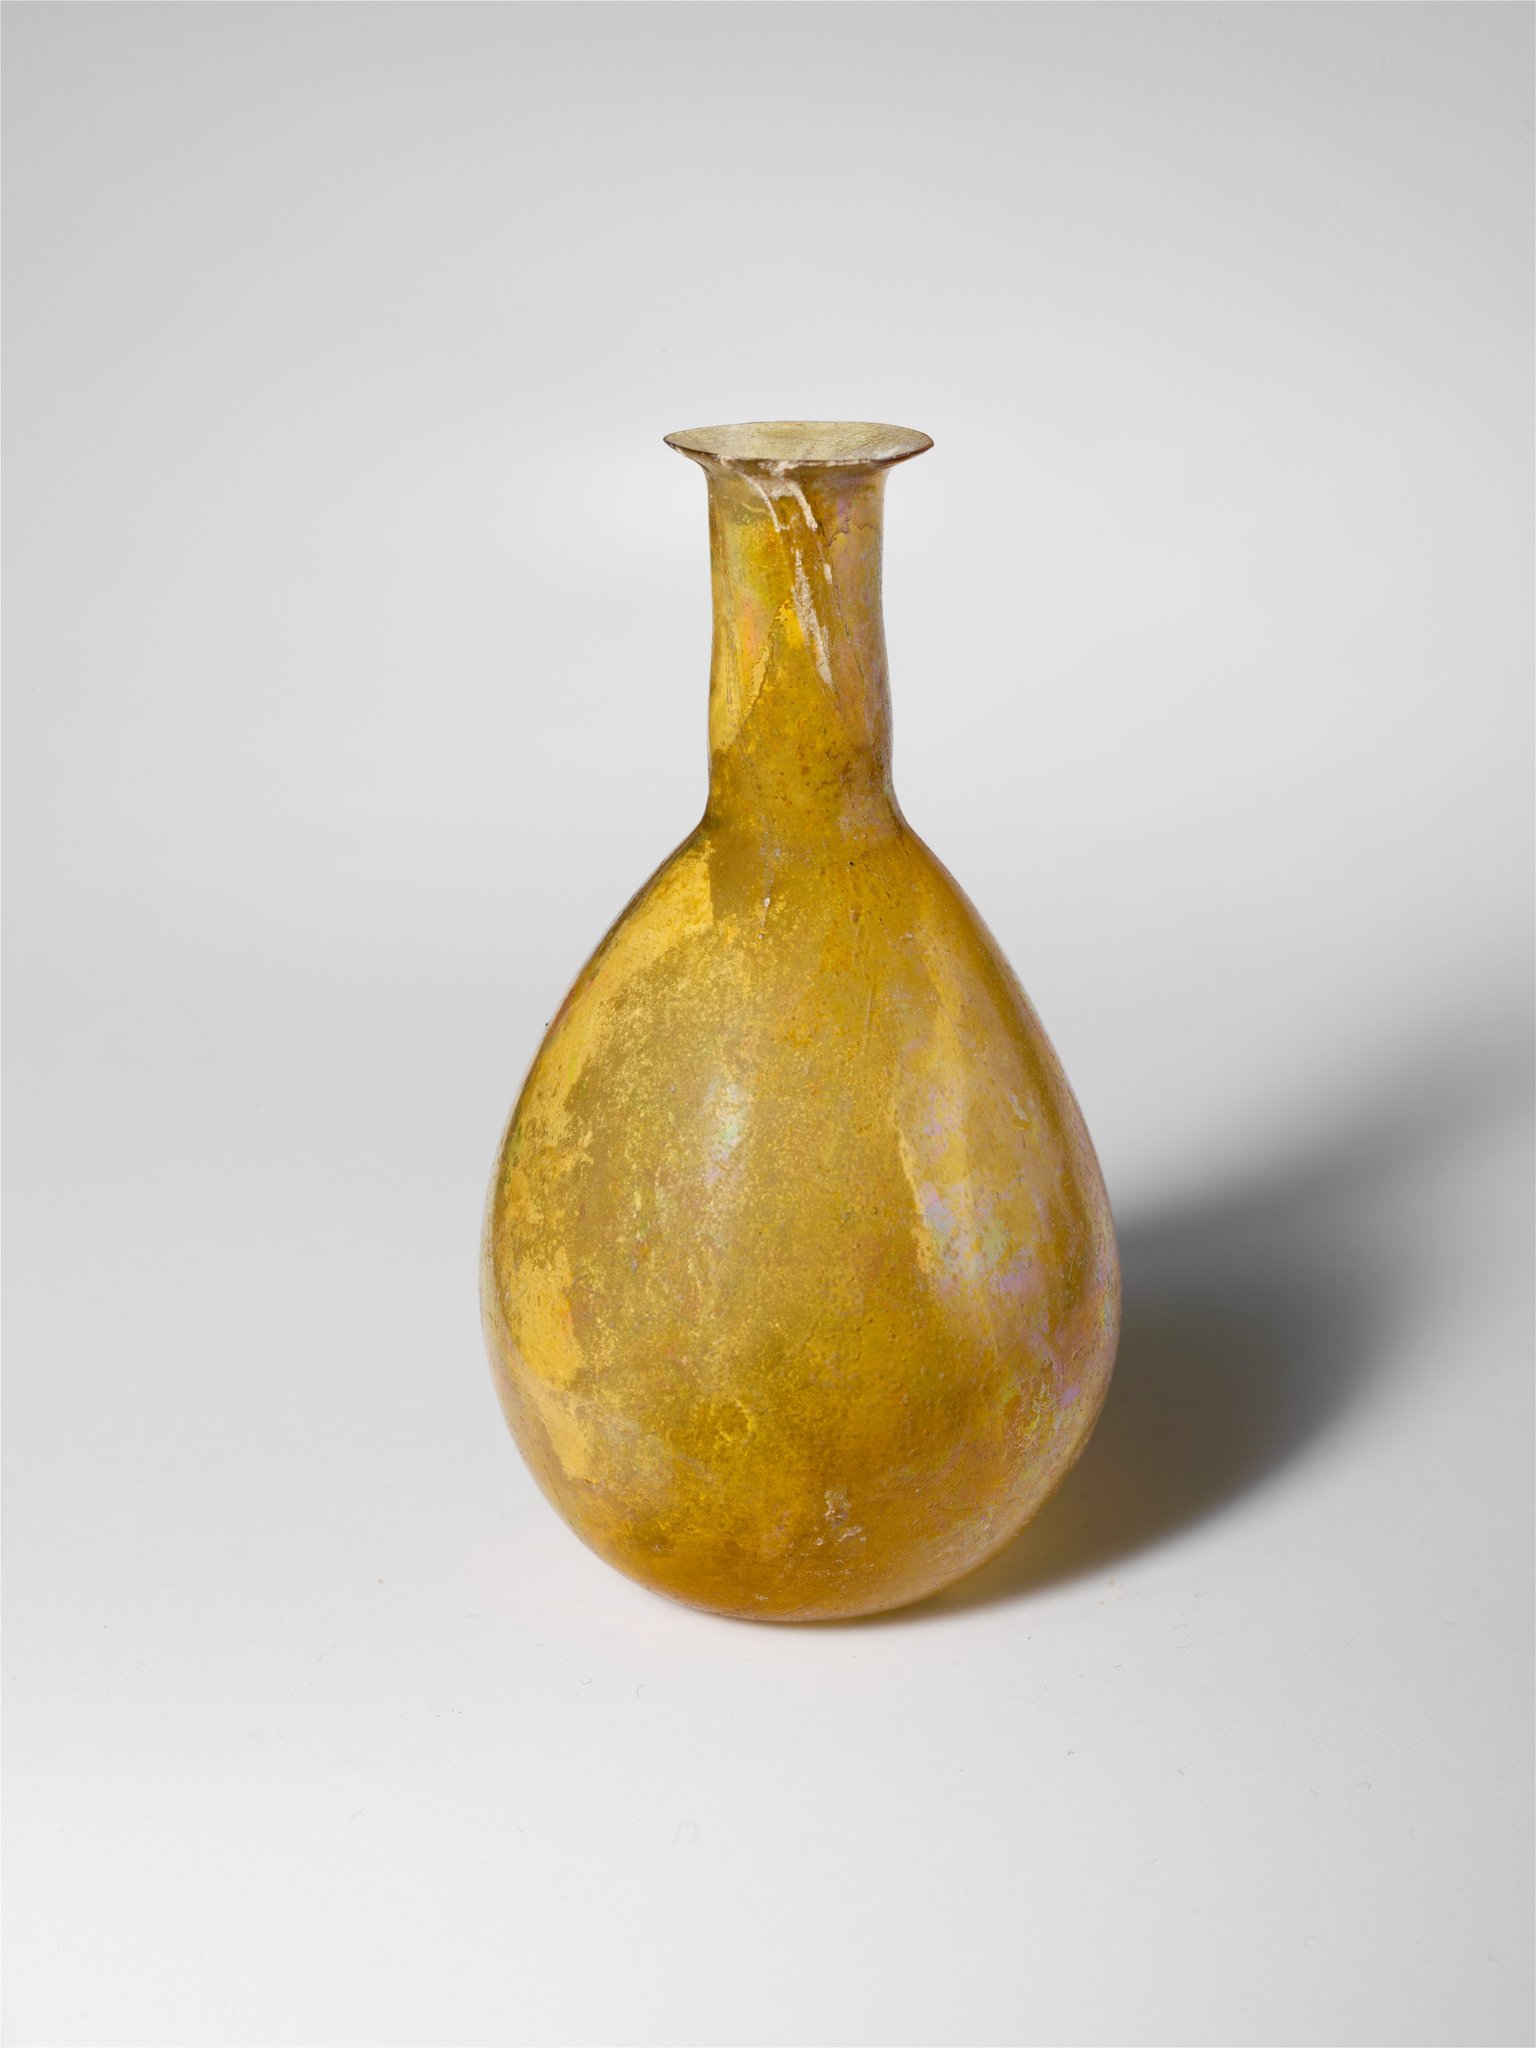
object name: perfume bottle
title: Glass perfume bottle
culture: roman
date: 1-100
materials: glass